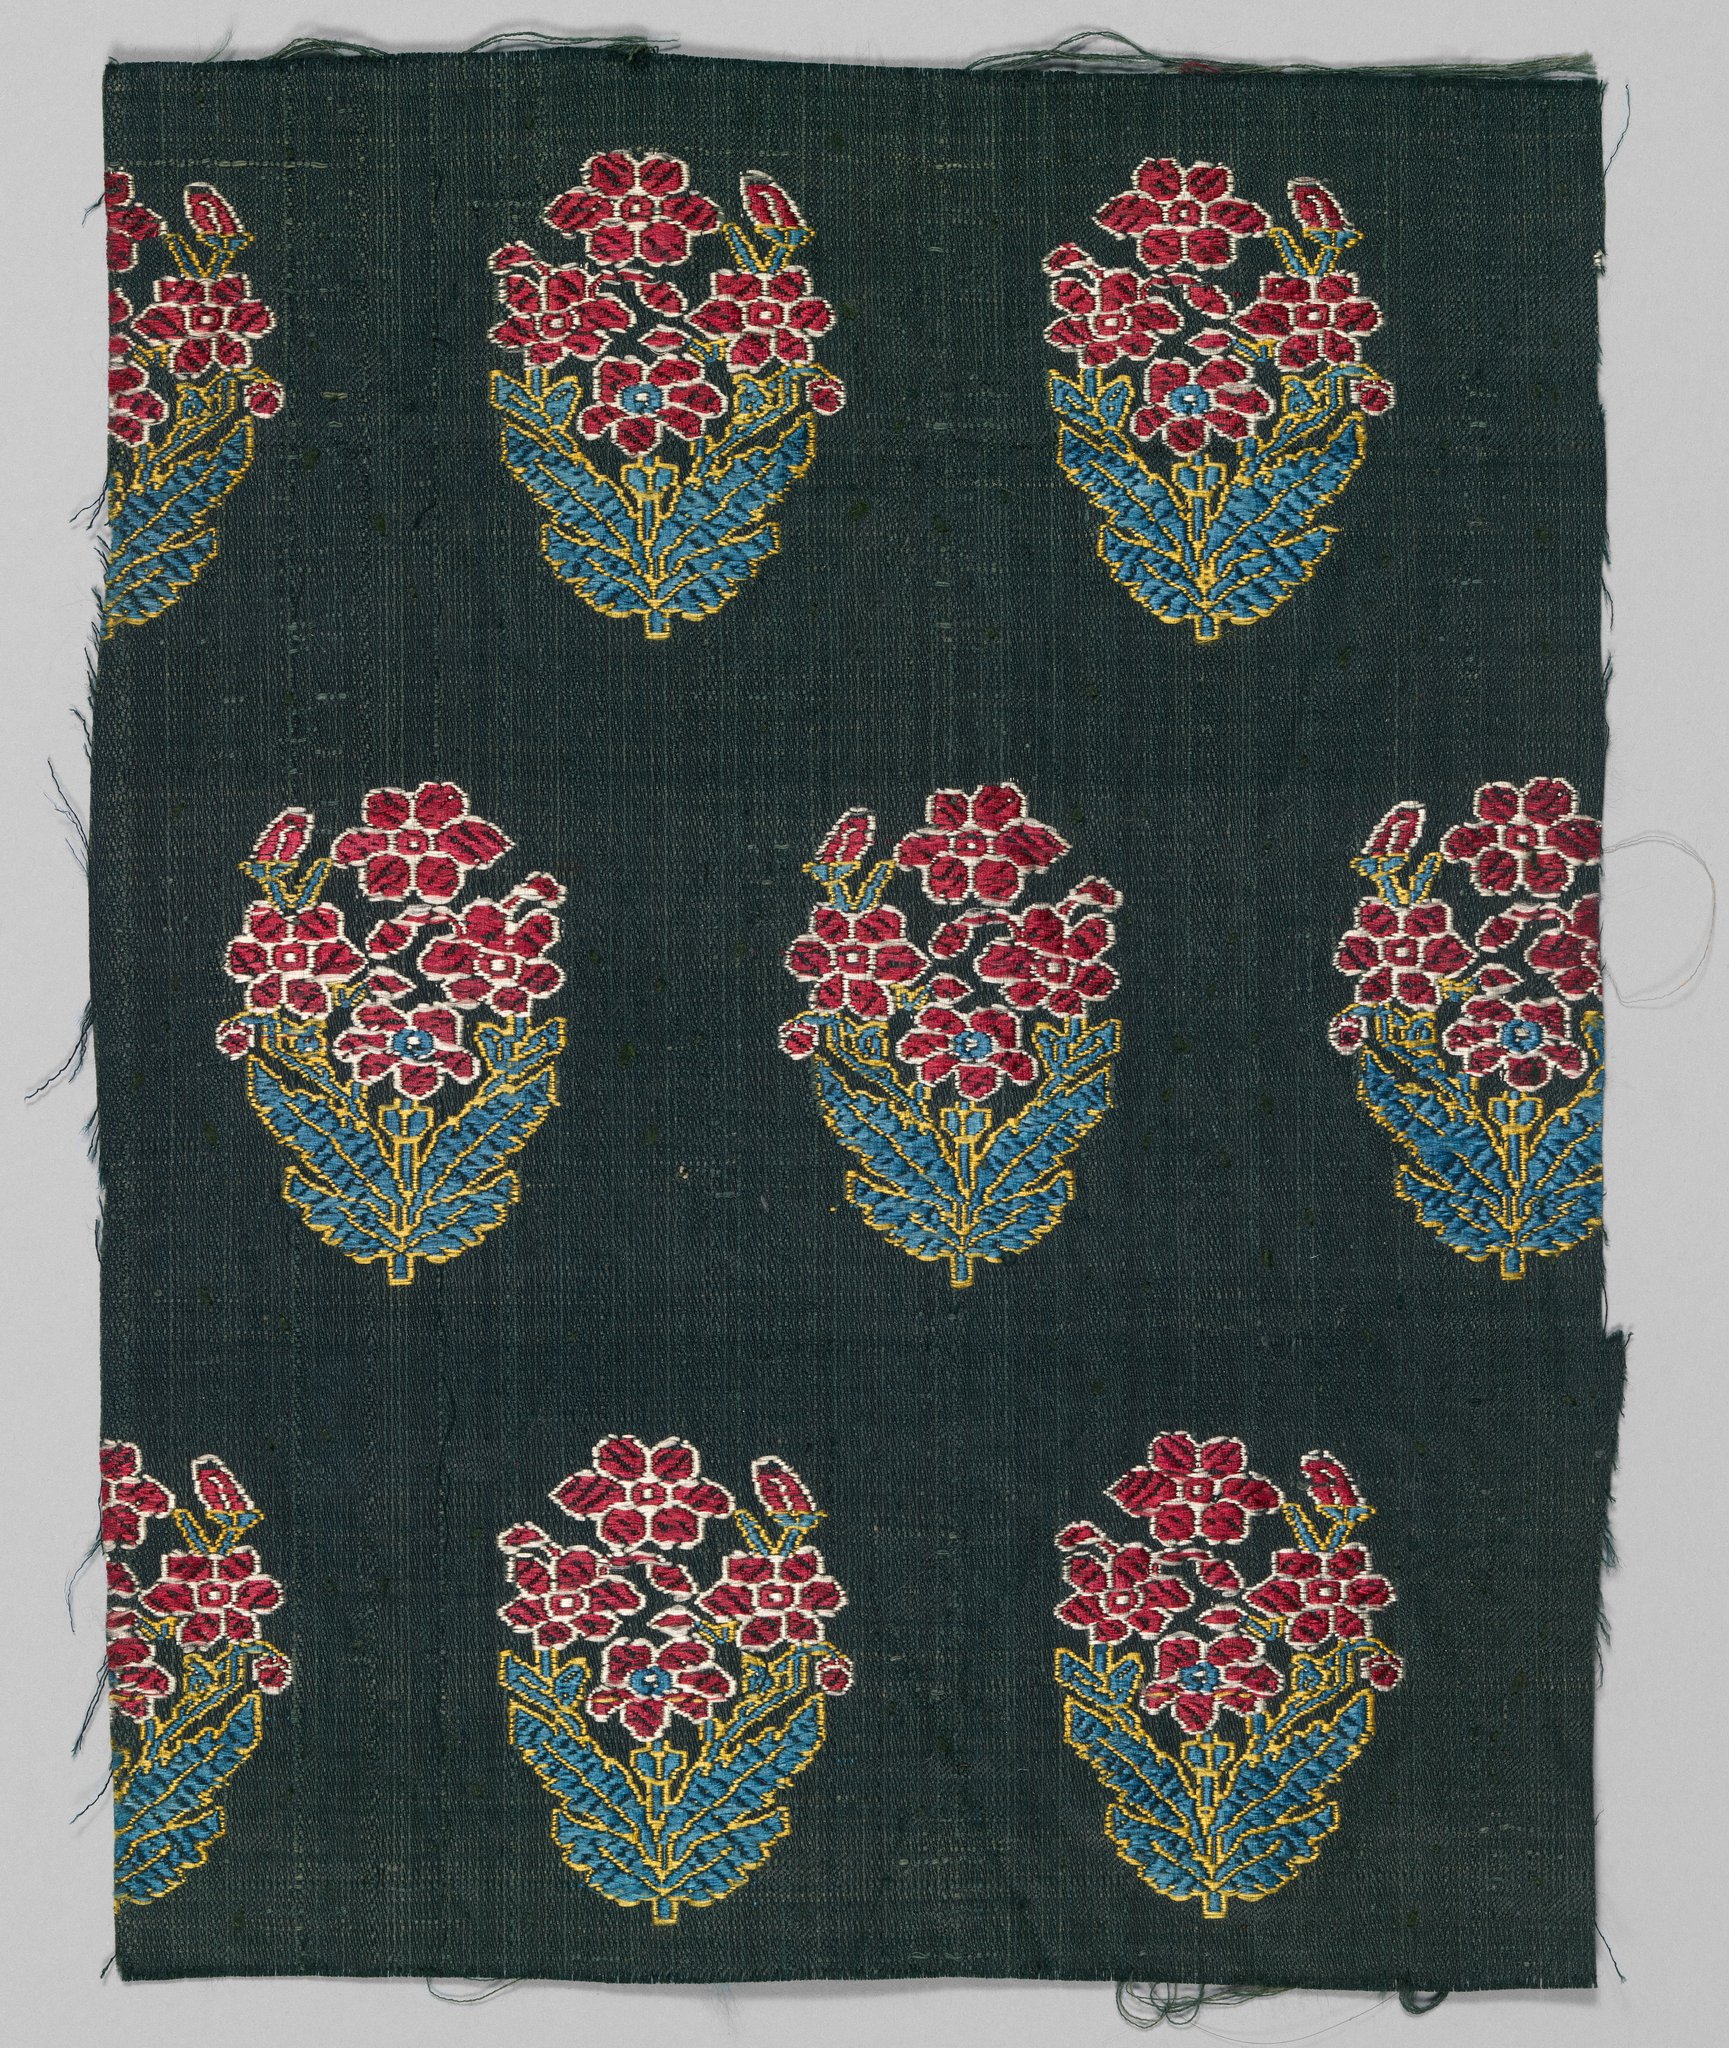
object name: textile fragment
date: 1701-1800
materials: metal thread, silk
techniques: brocade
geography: india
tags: flowers